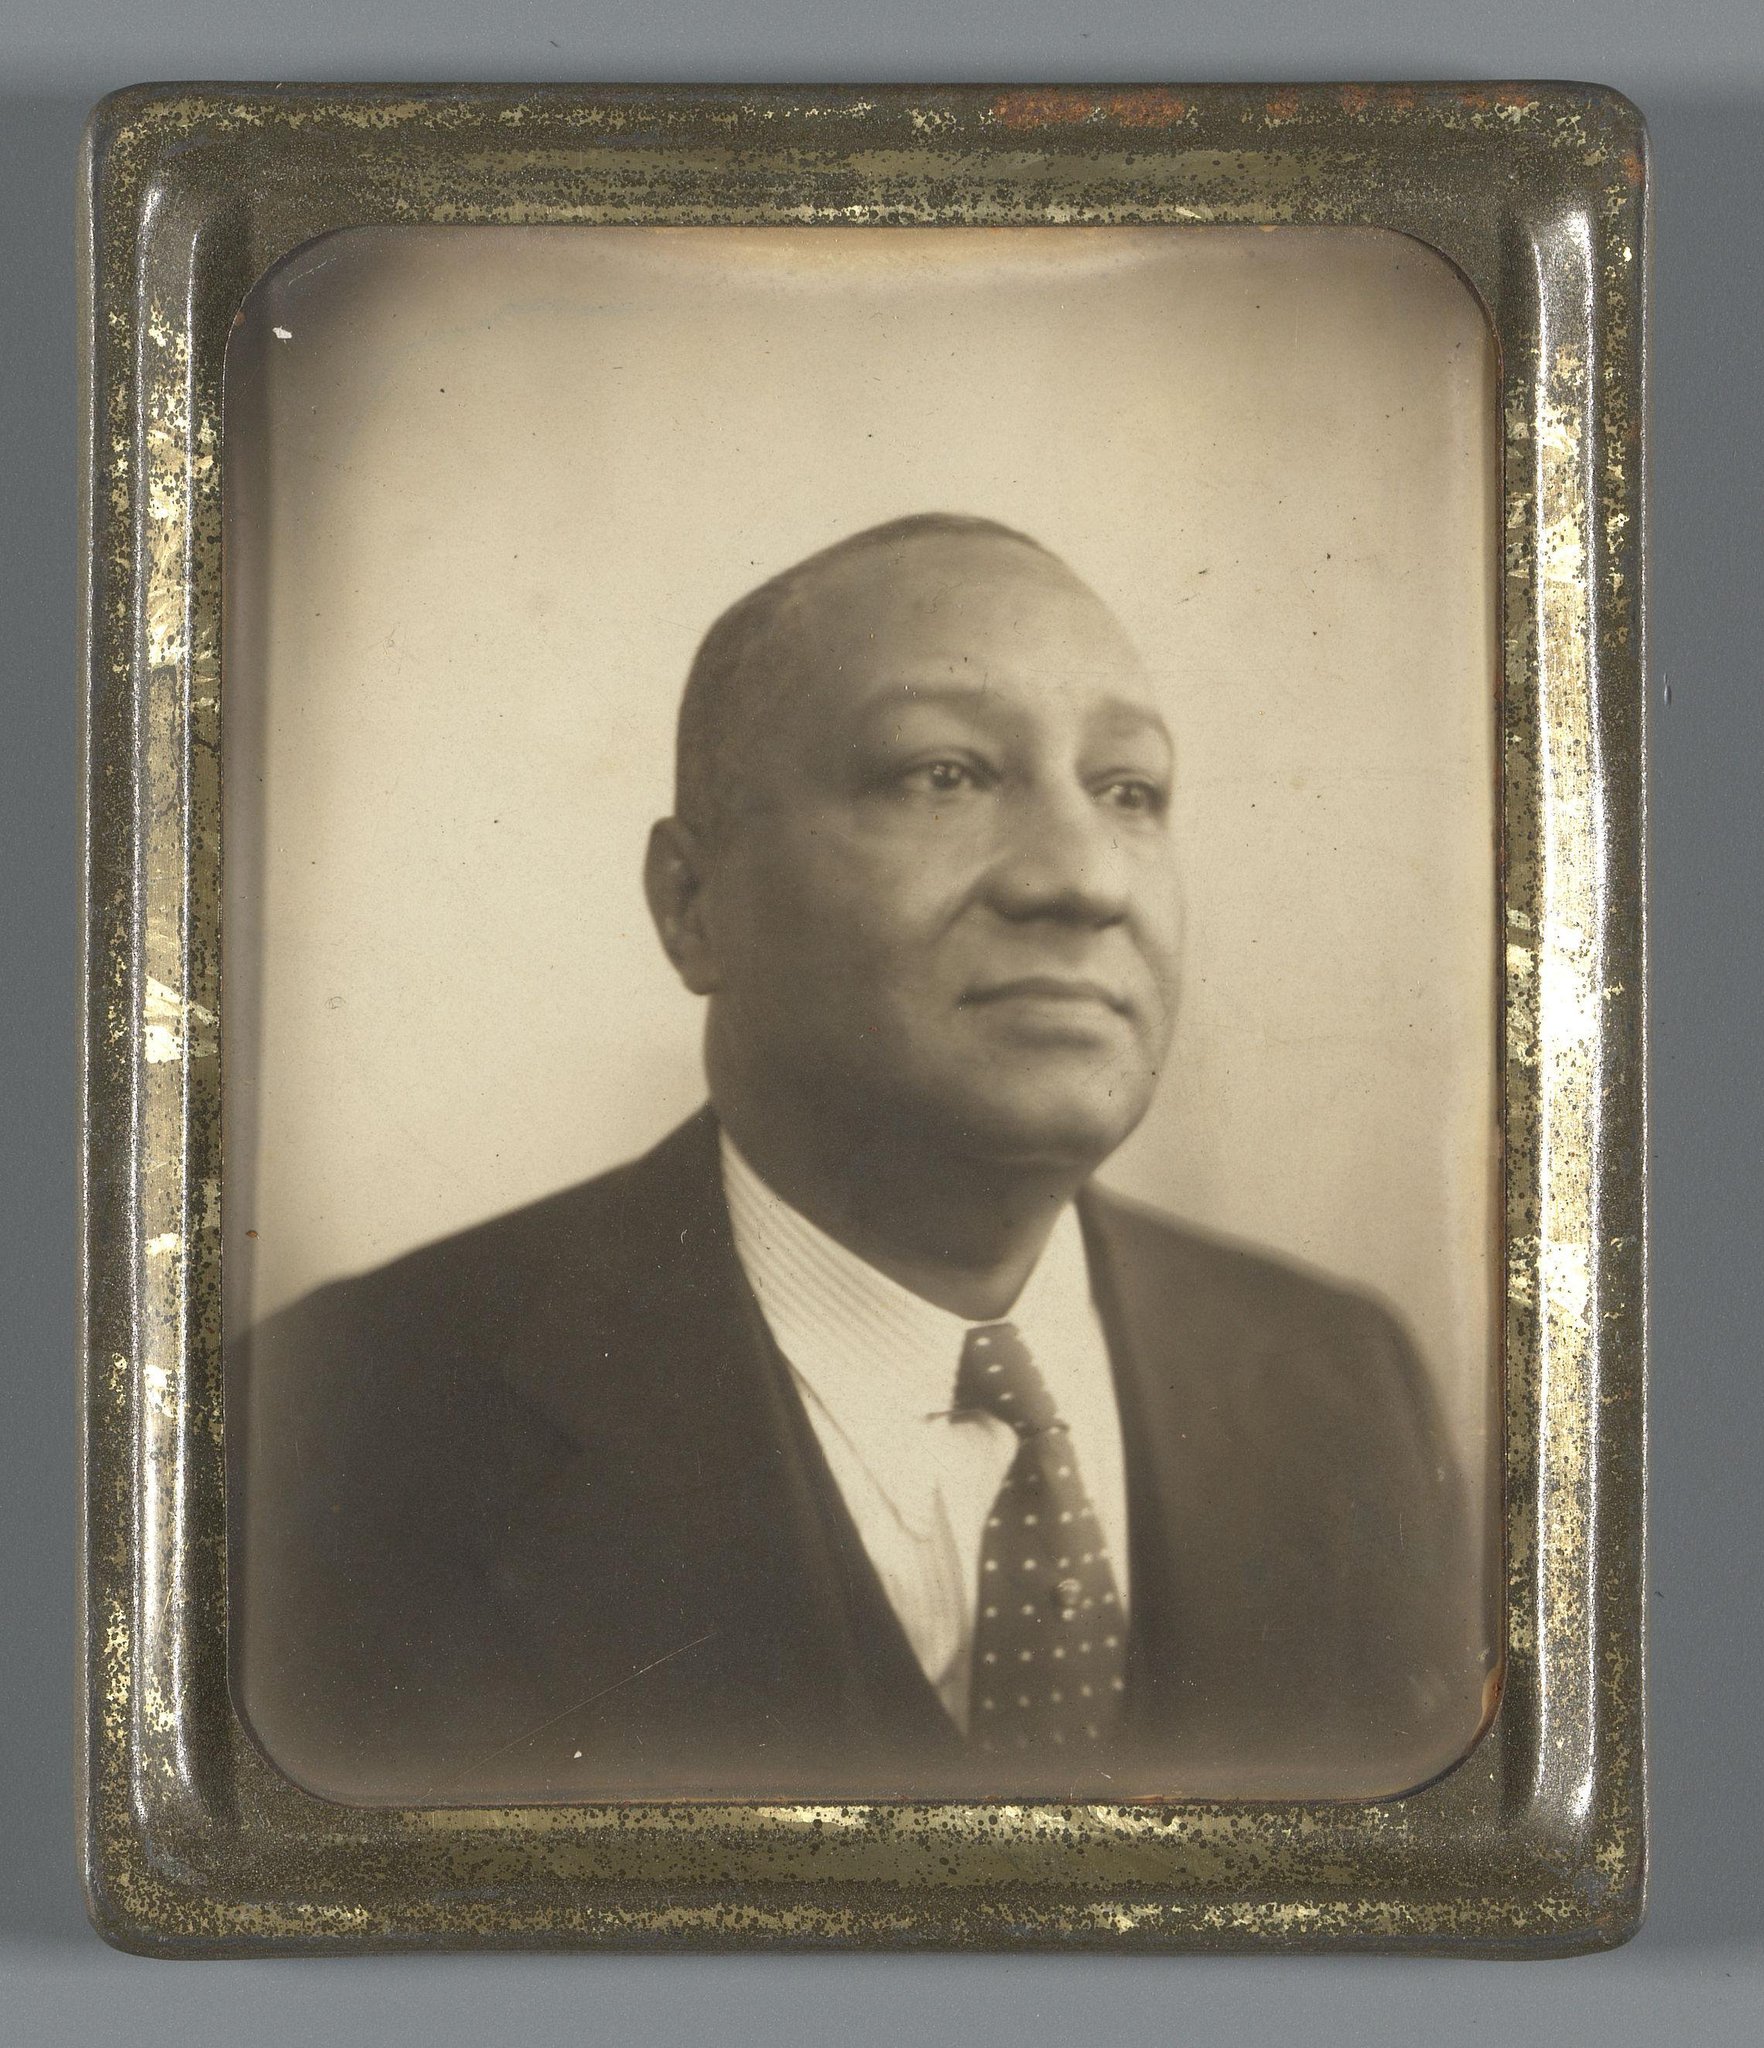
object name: photograph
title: Portret van Uncle Jack Cornell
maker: Anonymous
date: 1945-1949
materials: metal, photographic support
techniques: photography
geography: united states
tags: united states of america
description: Automaatfoto van Afro-Amerikaanse man in metalen lijstje.